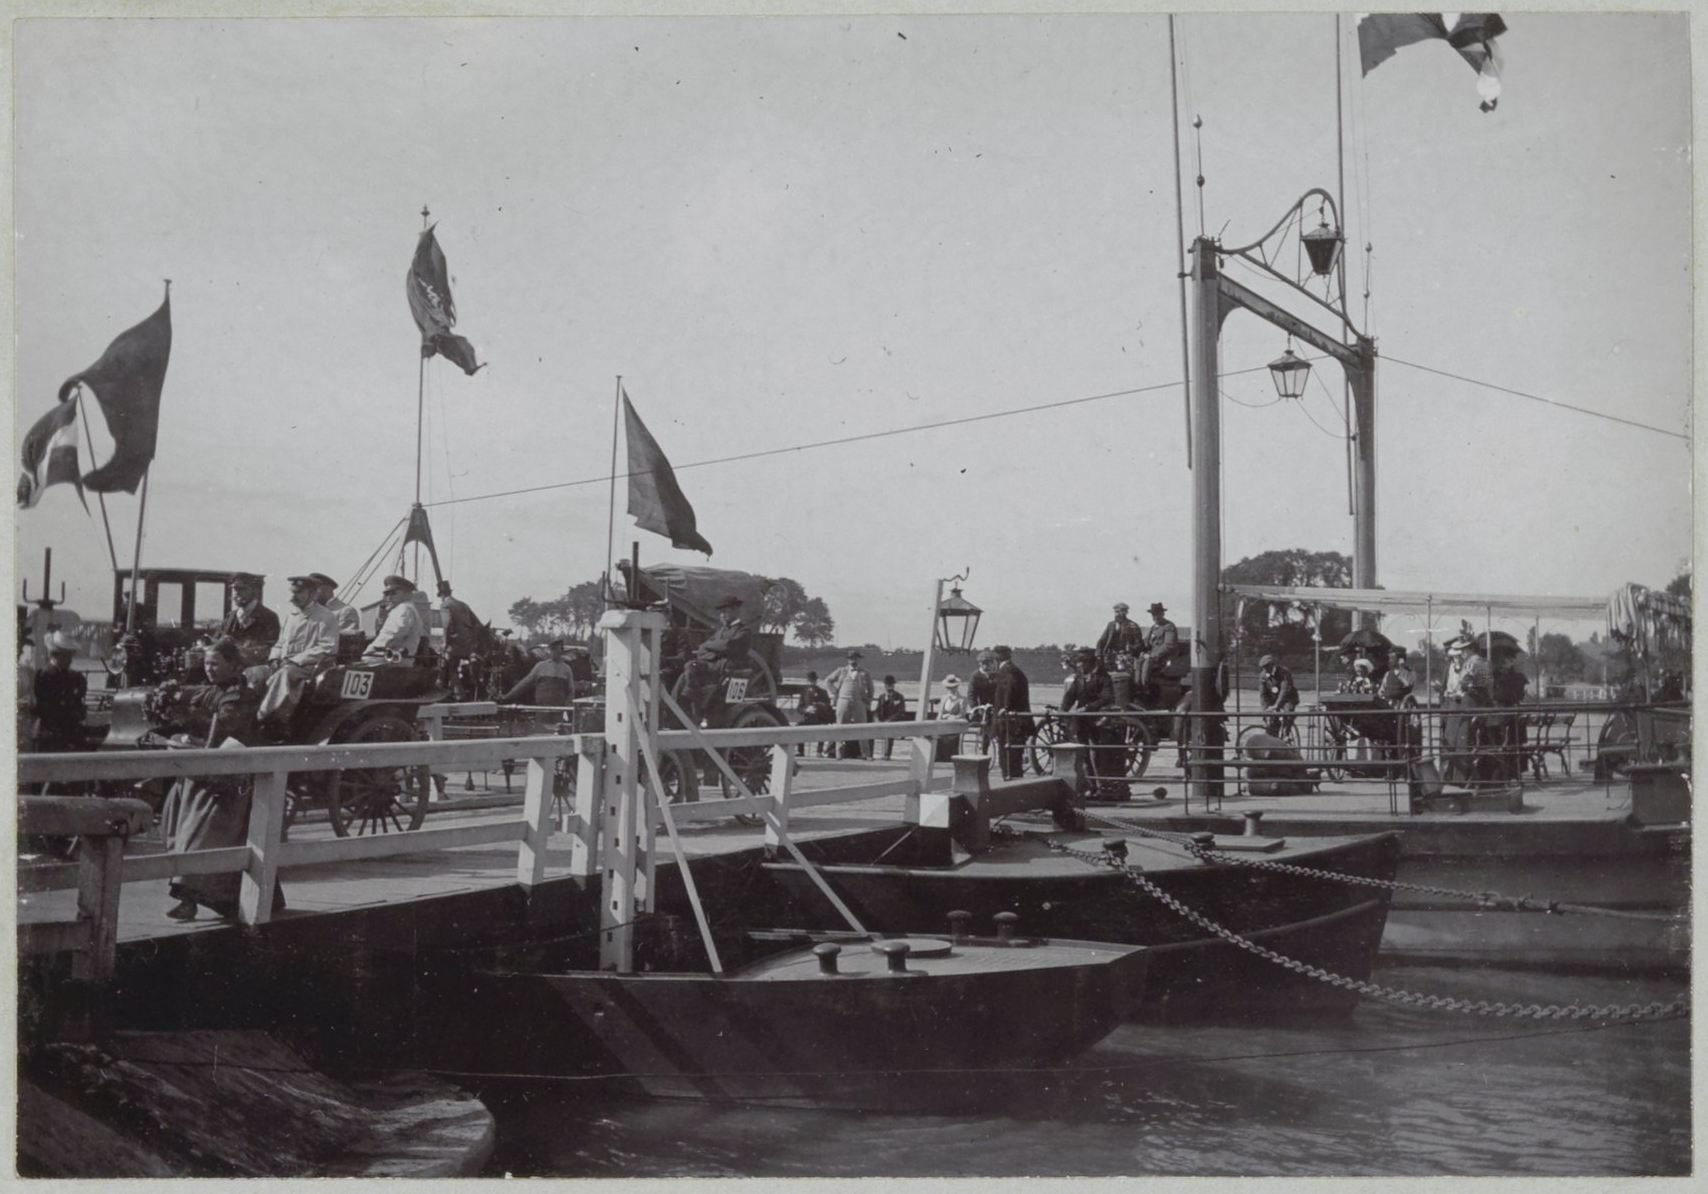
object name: photograph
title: Deelnemers aan de race Parijs-Amsterdam passeren in hun automobielen een pontonbrug te Nijmegen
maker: delizy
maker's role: manufacturer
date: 1807-1898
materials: paper, photographic support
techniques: collodion silver print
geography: nijmegen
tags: motorcar racing, pontoon bridge, automobile, nijmegen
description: Onderdeel van Fotoalbum van een Franse amateurfotograaf met opnames van uitstapjes in Frankrijk, Spanje, België, Luxemburg en Nederland, de eerste automobielen en autoraces.